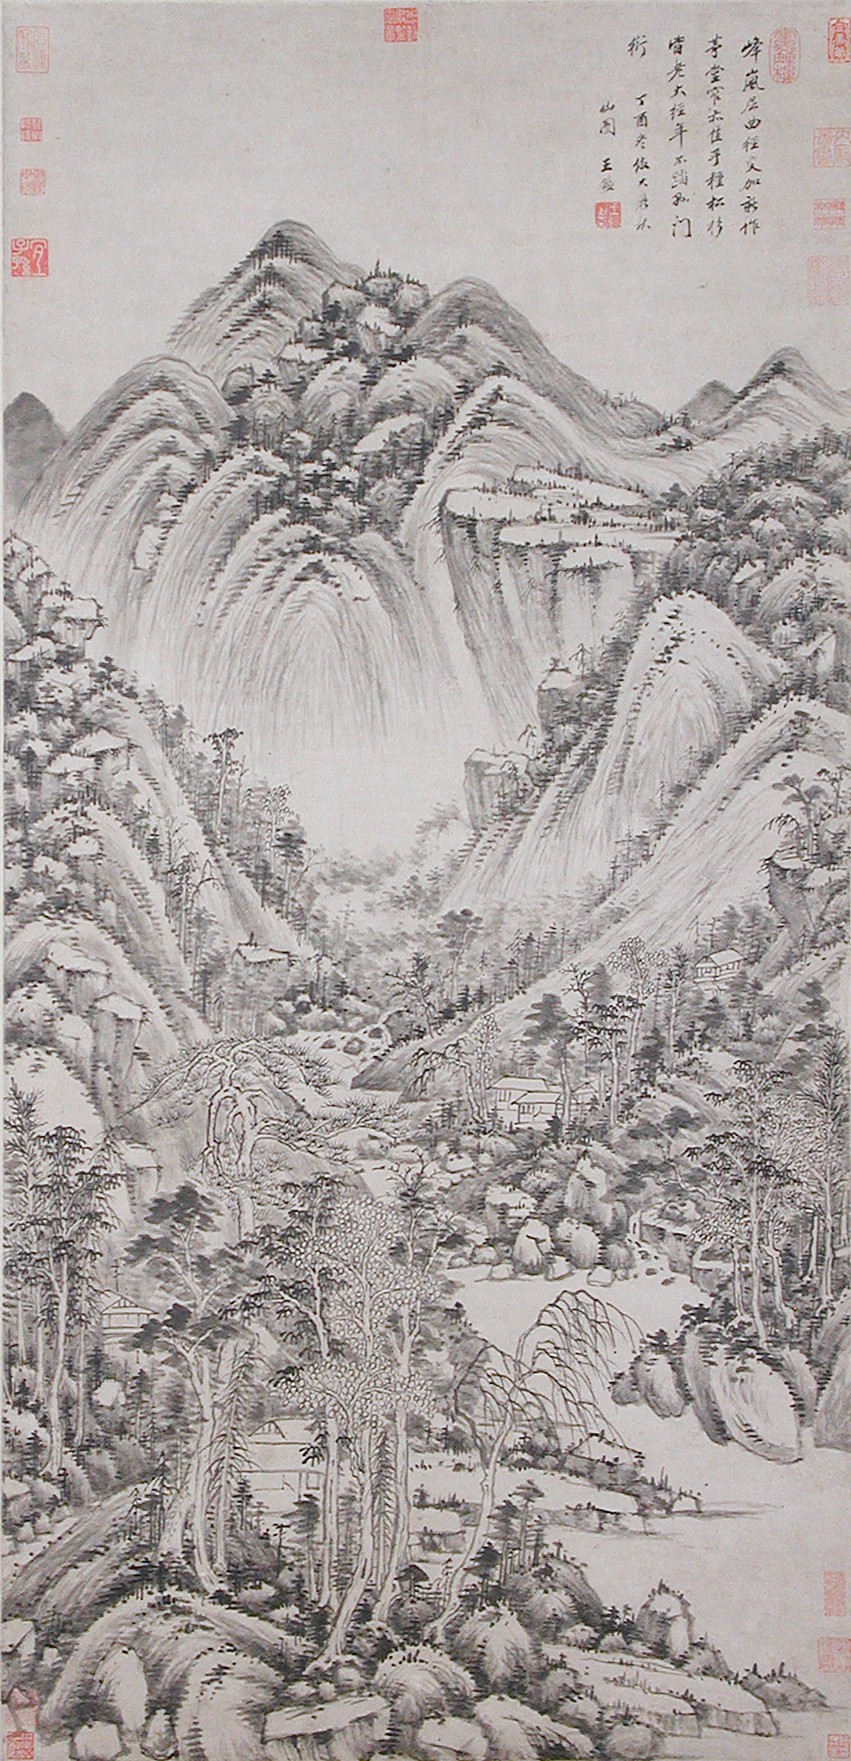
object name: hanging scroll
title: Landscape in the style of Huang Gongwang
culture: chinese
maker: wang jian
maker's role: artist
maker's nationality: chinese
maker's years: 1609-1677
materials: ink, paper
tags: mountains,landscapes